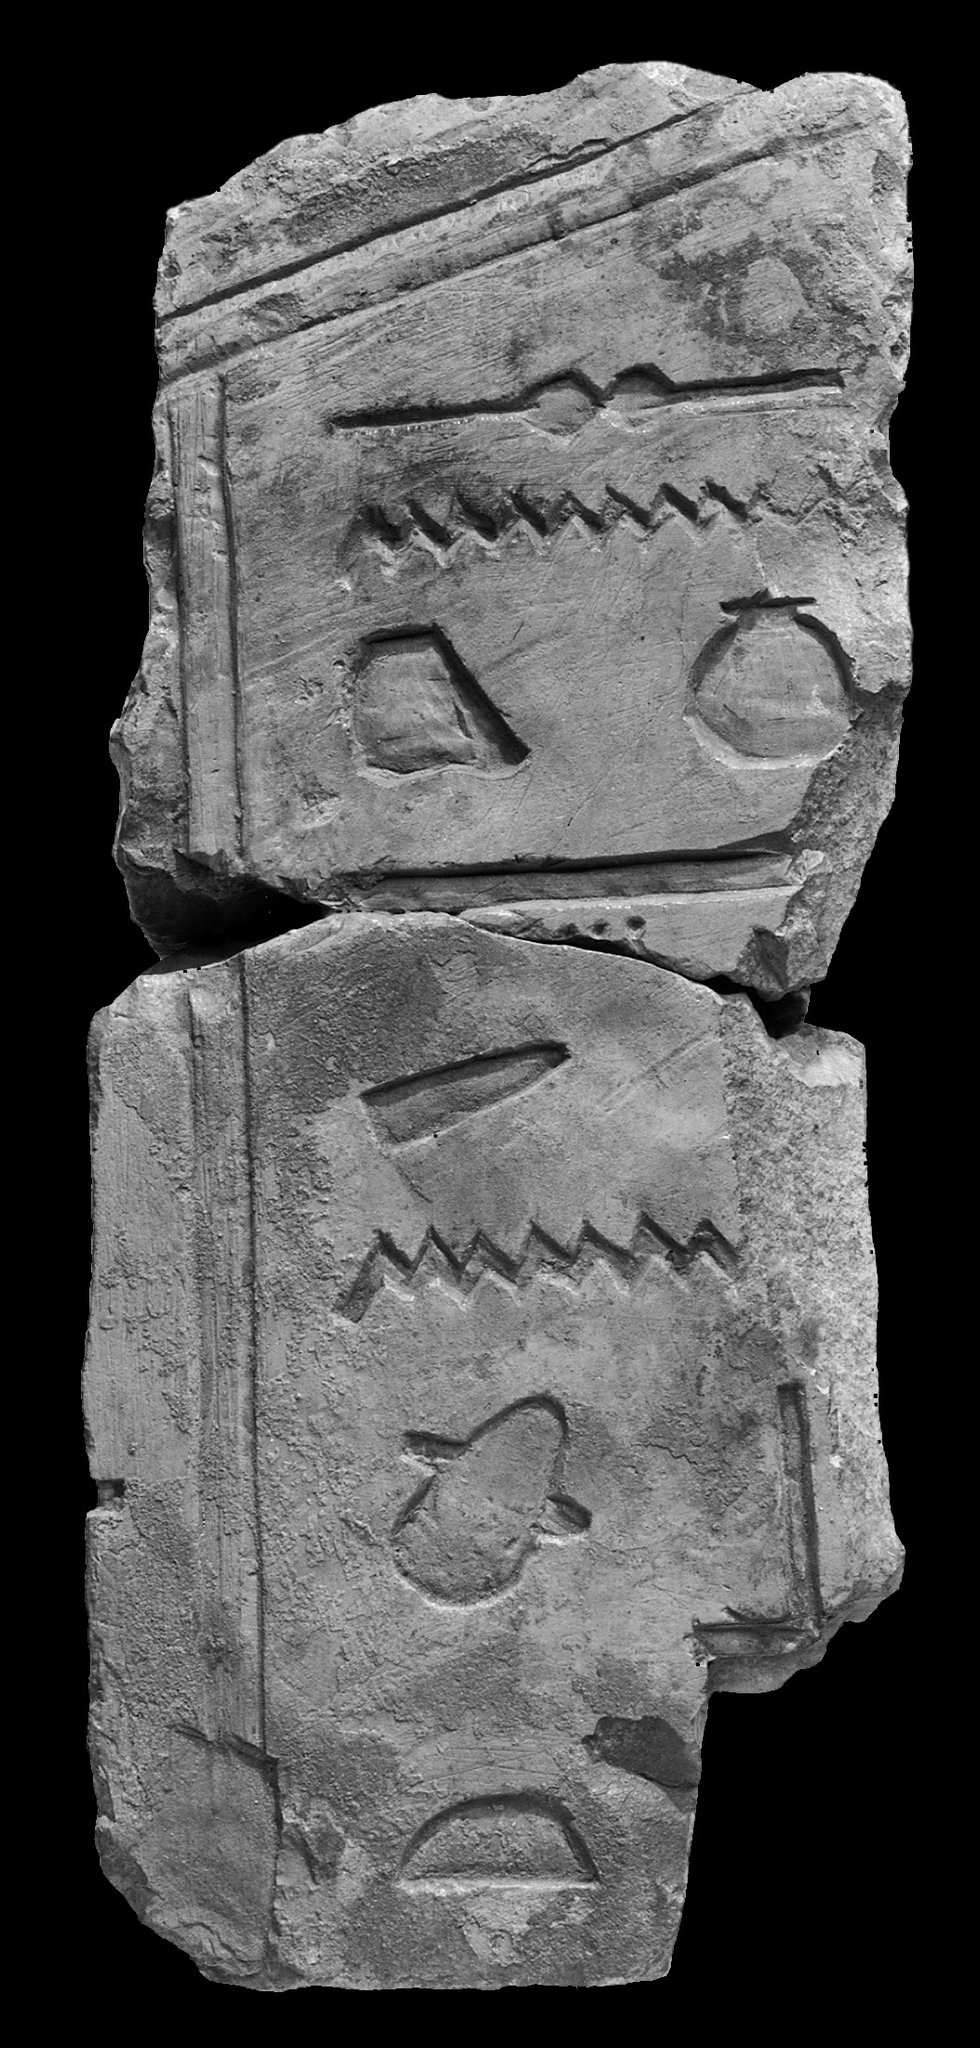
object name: relief, tomb of nespekashuty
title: Sunk relief fragment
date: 664-610 BCE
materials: limestone, varnish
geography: egypt